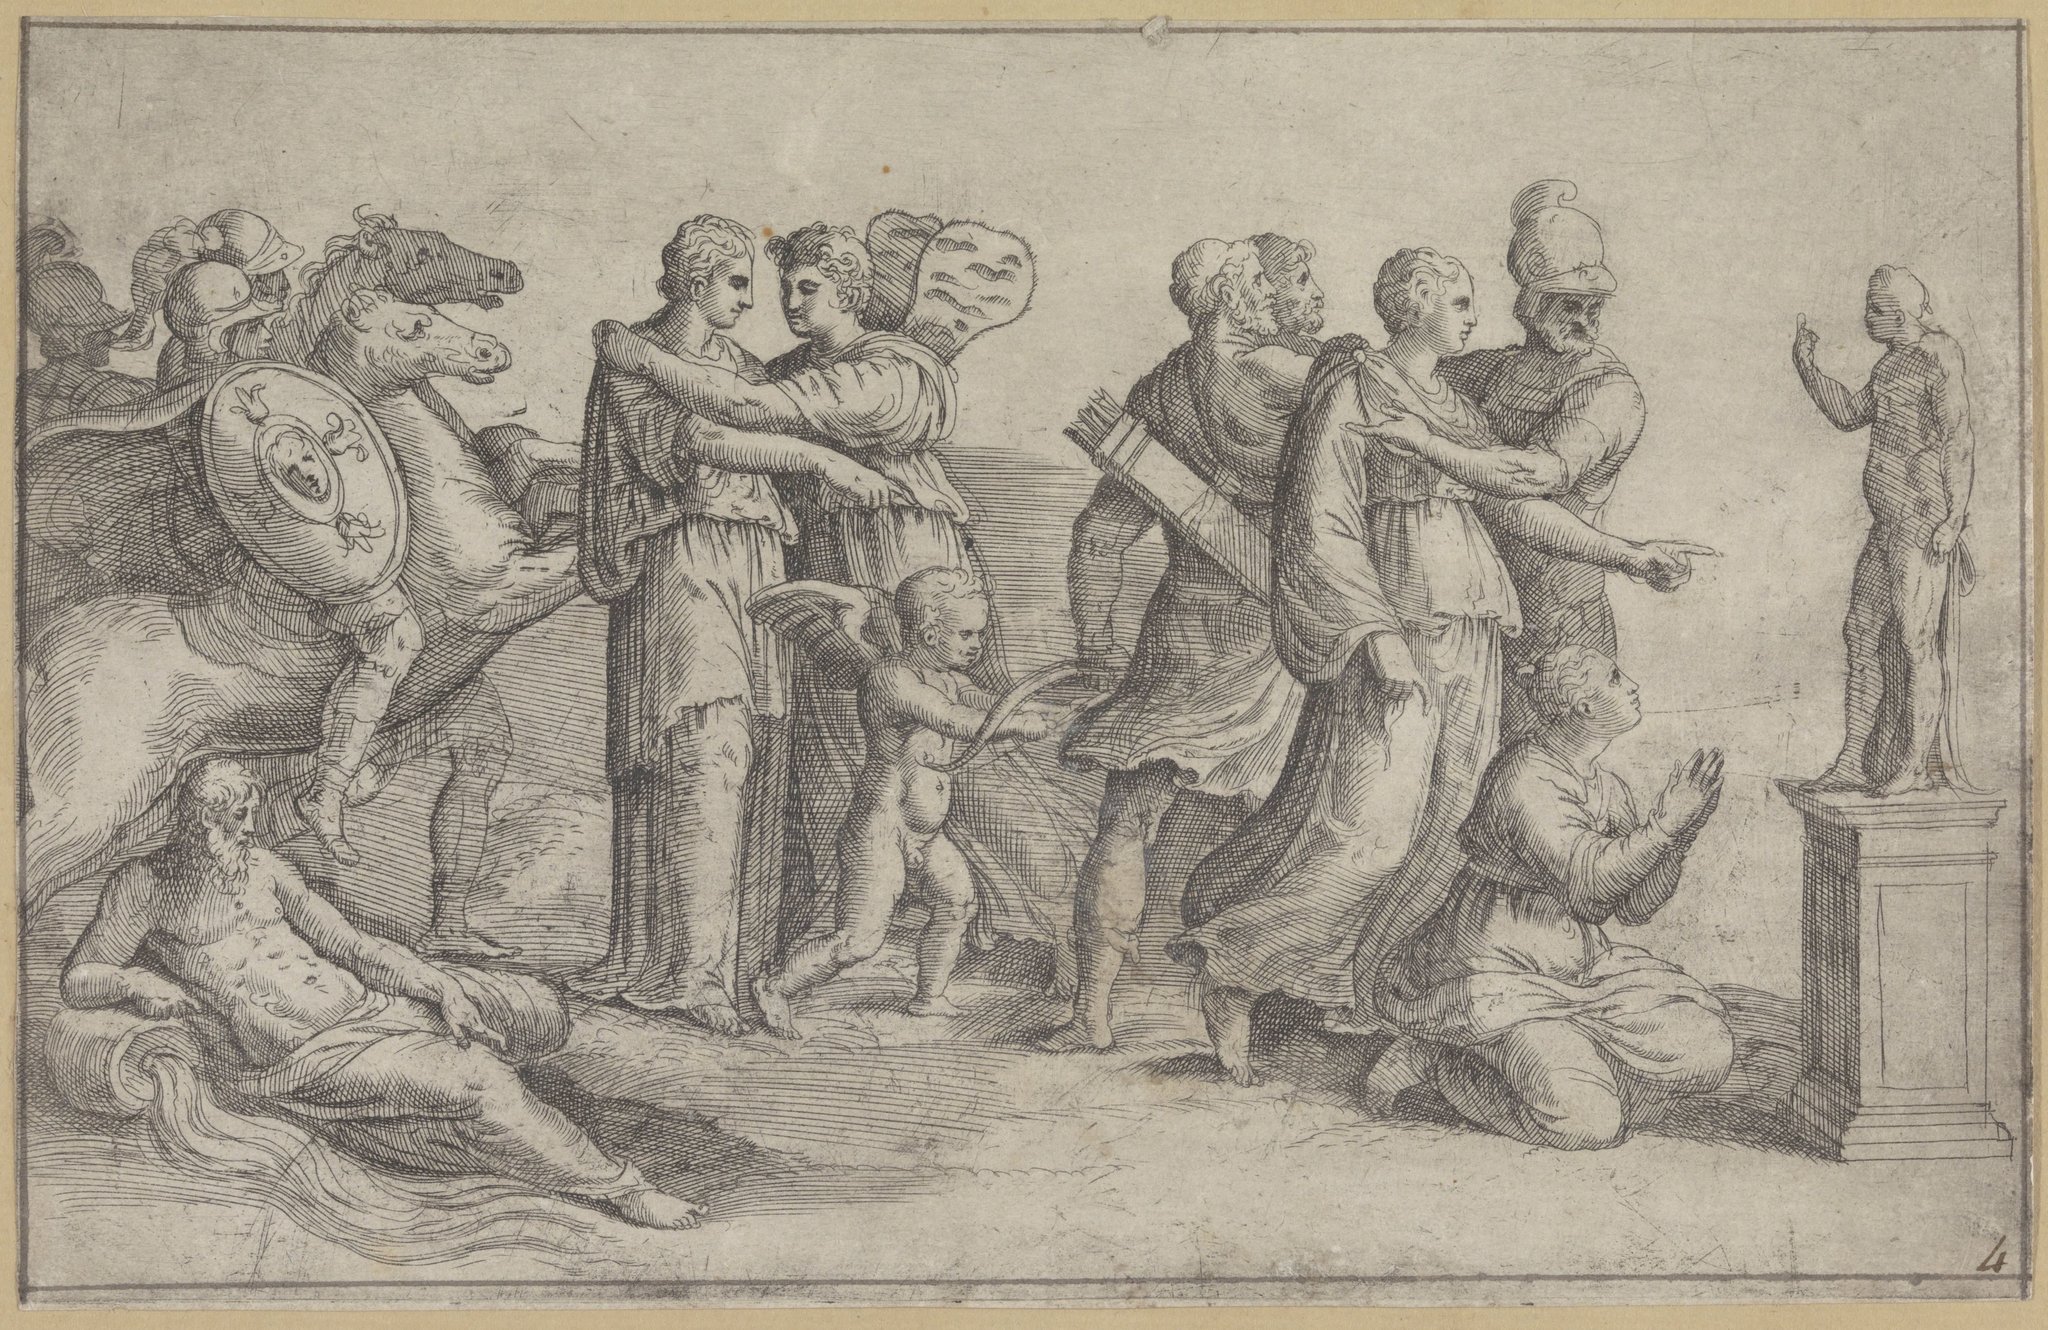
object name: print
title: Krijgslieden met hun vrouwen bij godenbeeld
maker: battista franco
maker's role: draughtsman, painter, print maker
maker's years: 1510-1561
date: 1520-1561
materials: paper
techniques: engraving, etching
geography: italy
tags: (public) prayer, the soldier; the soldier's life, cupids: 'amores', 'amoretti', 'putti'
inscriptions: collector's mark: Lugt 11, number: ‘4’, collector's mark: Lugt 10, collector's mark: ‘Hinloopen’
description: Een jonge vrouw zit geknield voor een Romeins godenbeeld. Achter haar staan een vrouw, soldaten, een gevleugelde figuur, een putto en ligt een riviergod (mogelijk de Tiber).